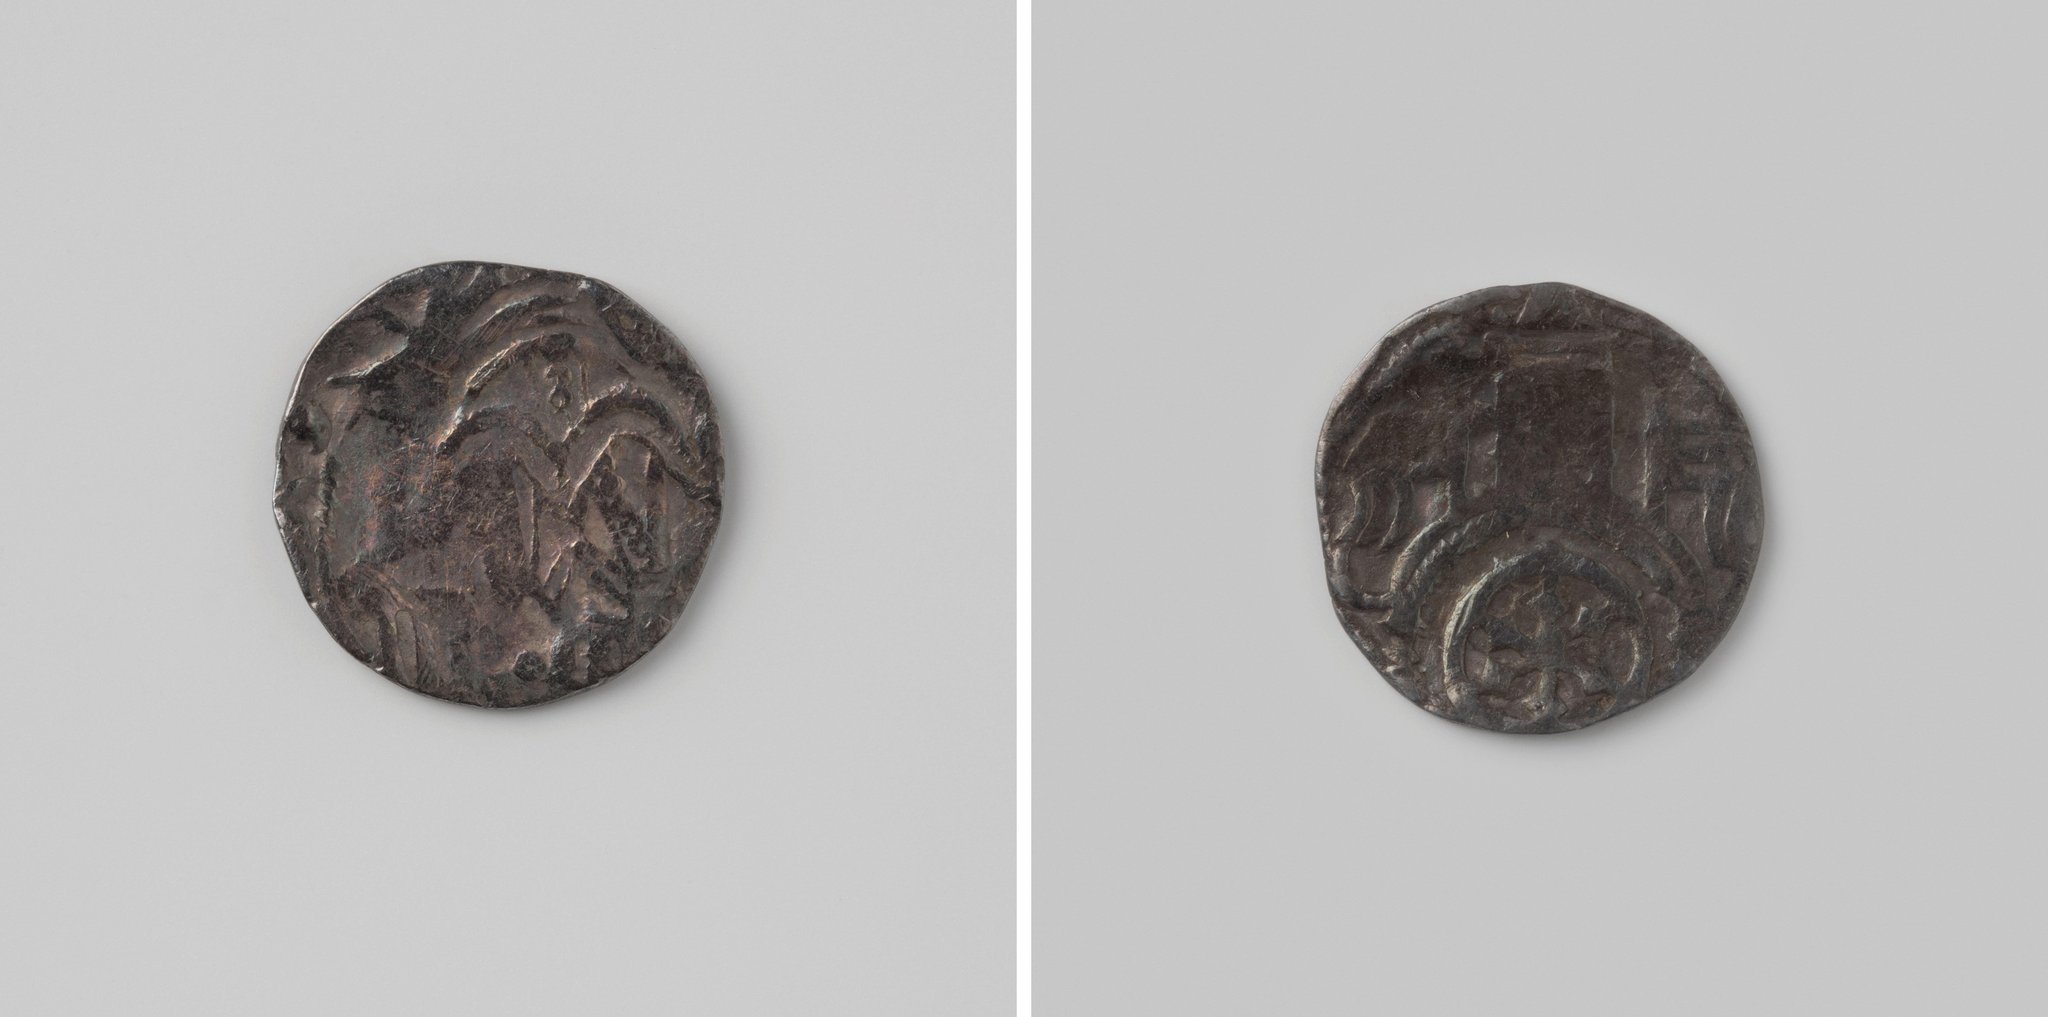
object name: coin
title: Penning uit het bisdom Osnabrück van Konrad II von Rietberg, 1270-1297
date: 1270-1297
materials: silver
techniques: striking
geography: osnabrück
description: Zilveren munt. Voorzijde: portret van bisschop van voren met in rechterhand staf. Keerzijde: kerkgebouw met poort, waarin rad, wapen van Osnabrück.